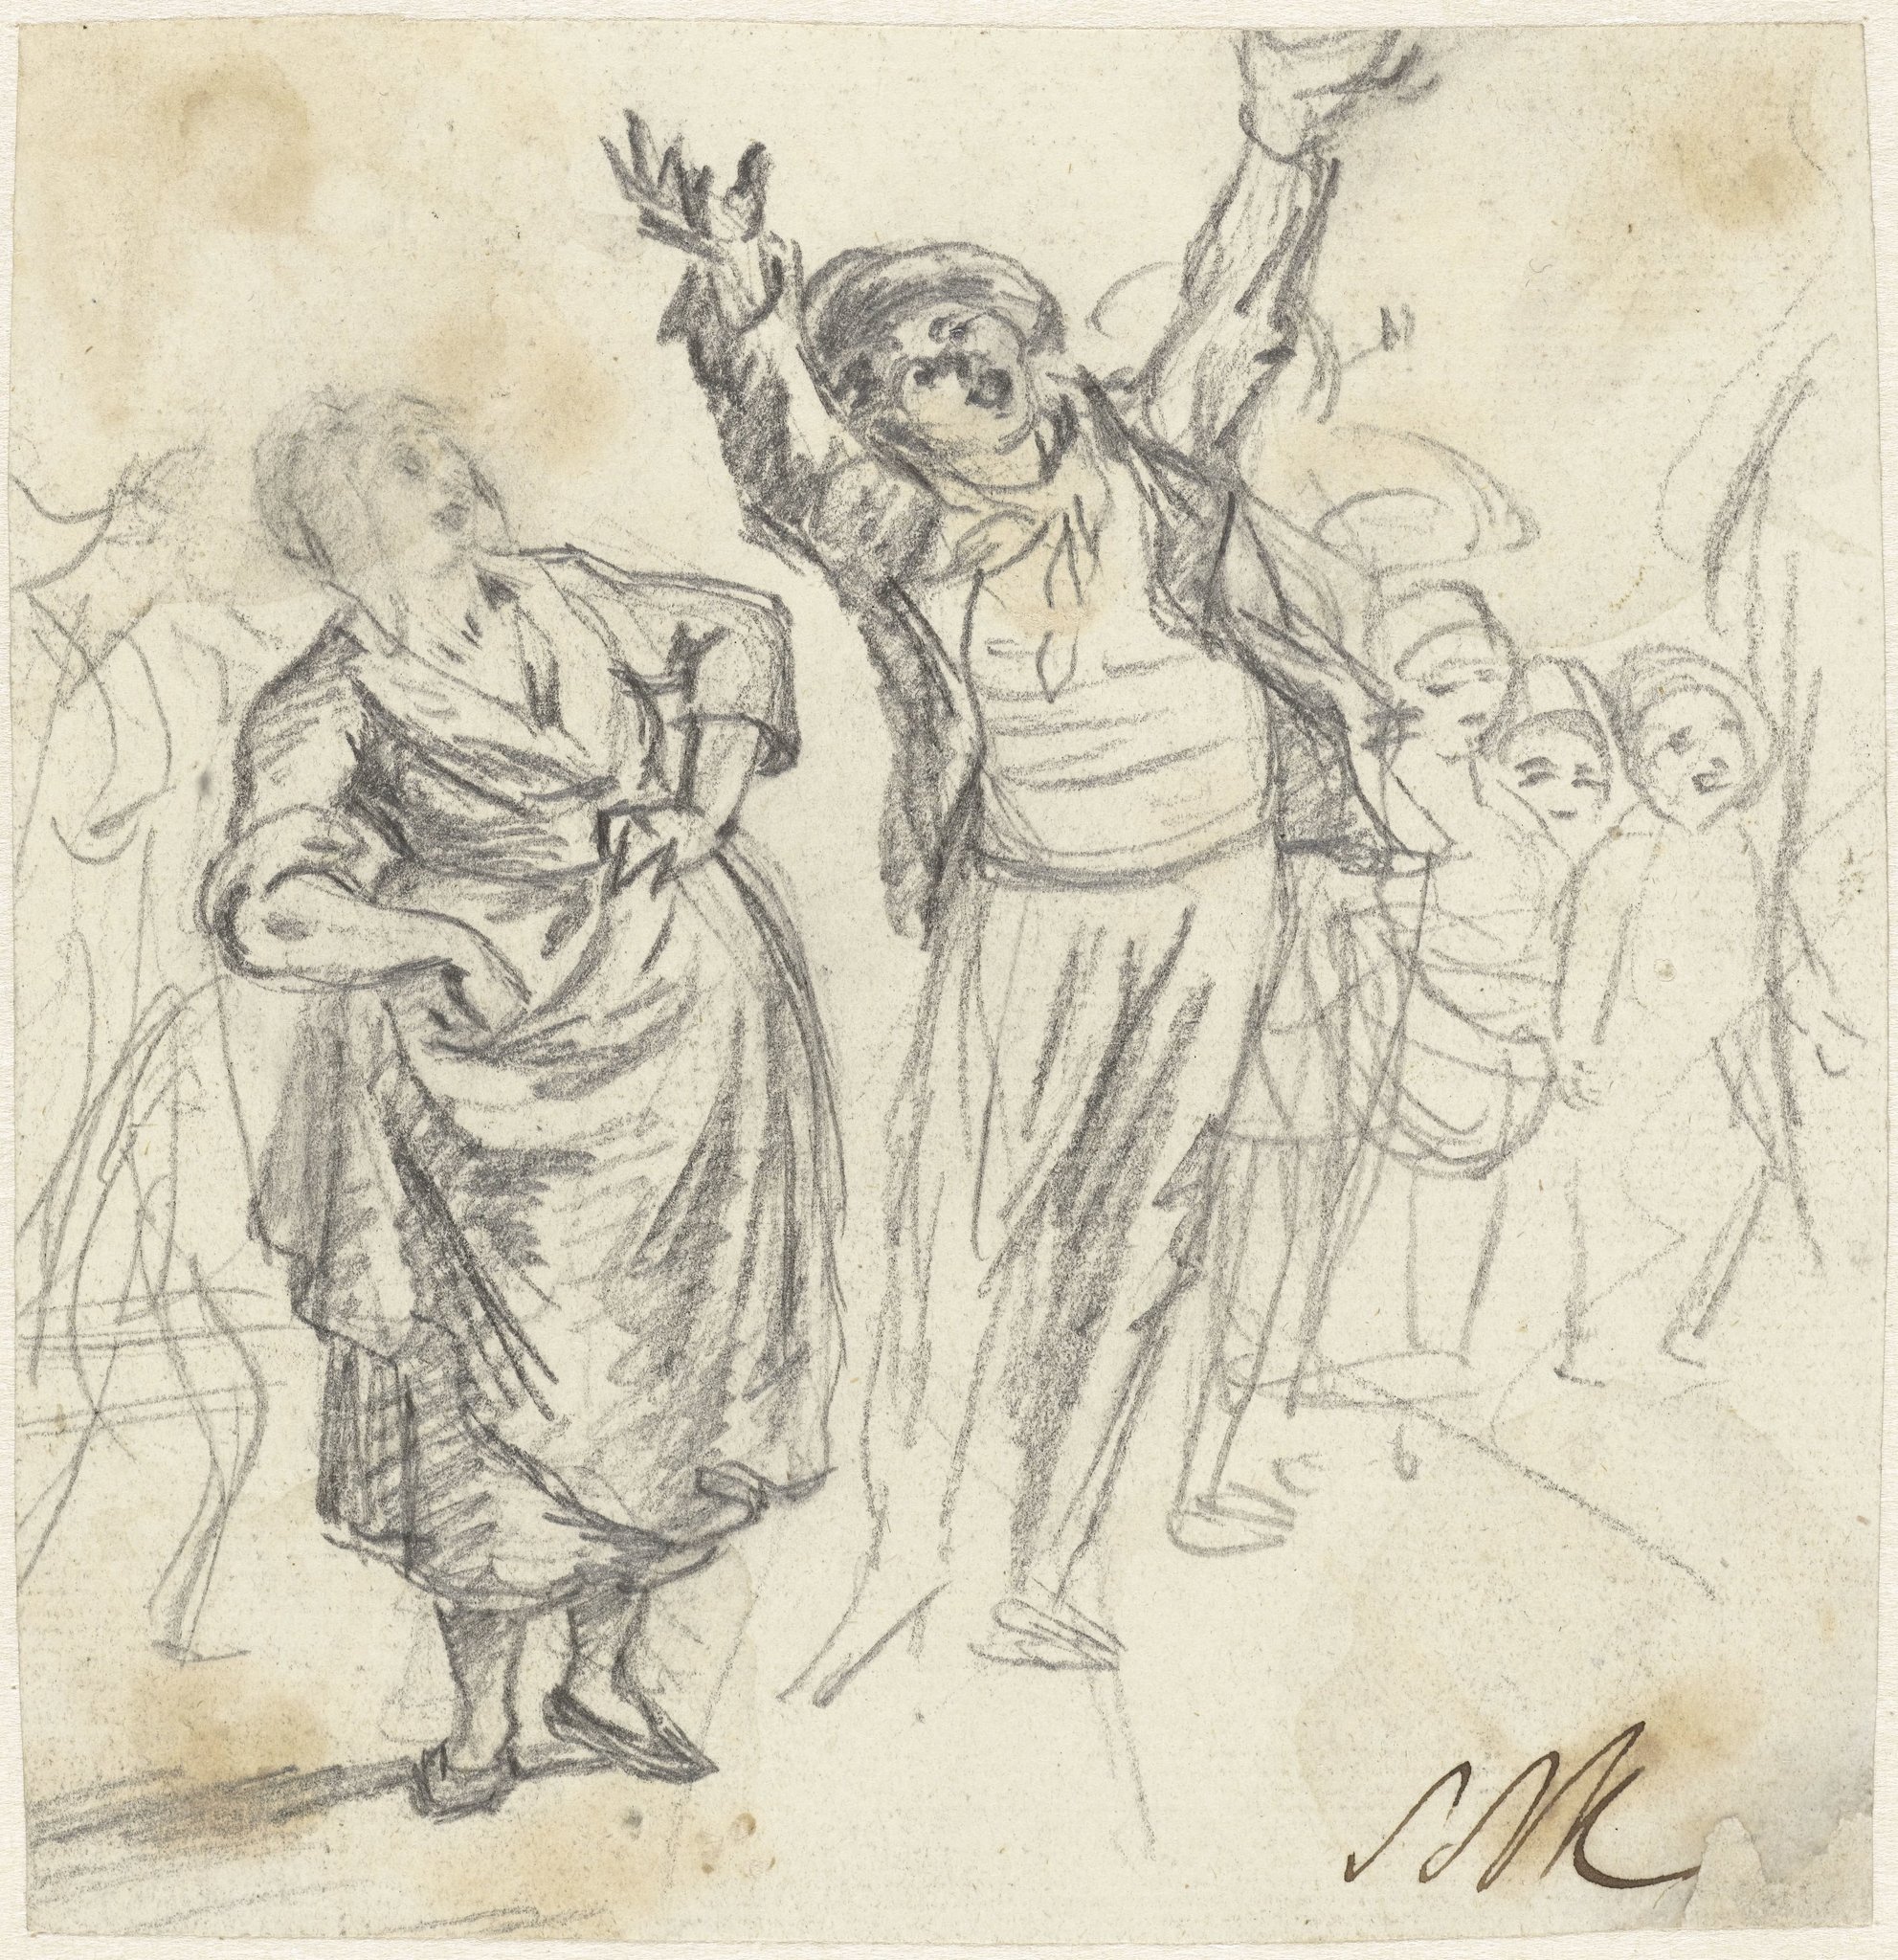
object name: drawing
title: Toeschouwers bij een straatvuur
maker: simon andreas krausz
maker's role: draughtsman, print maker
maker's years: 1760-1825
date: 1770-1825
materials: paper, pencil